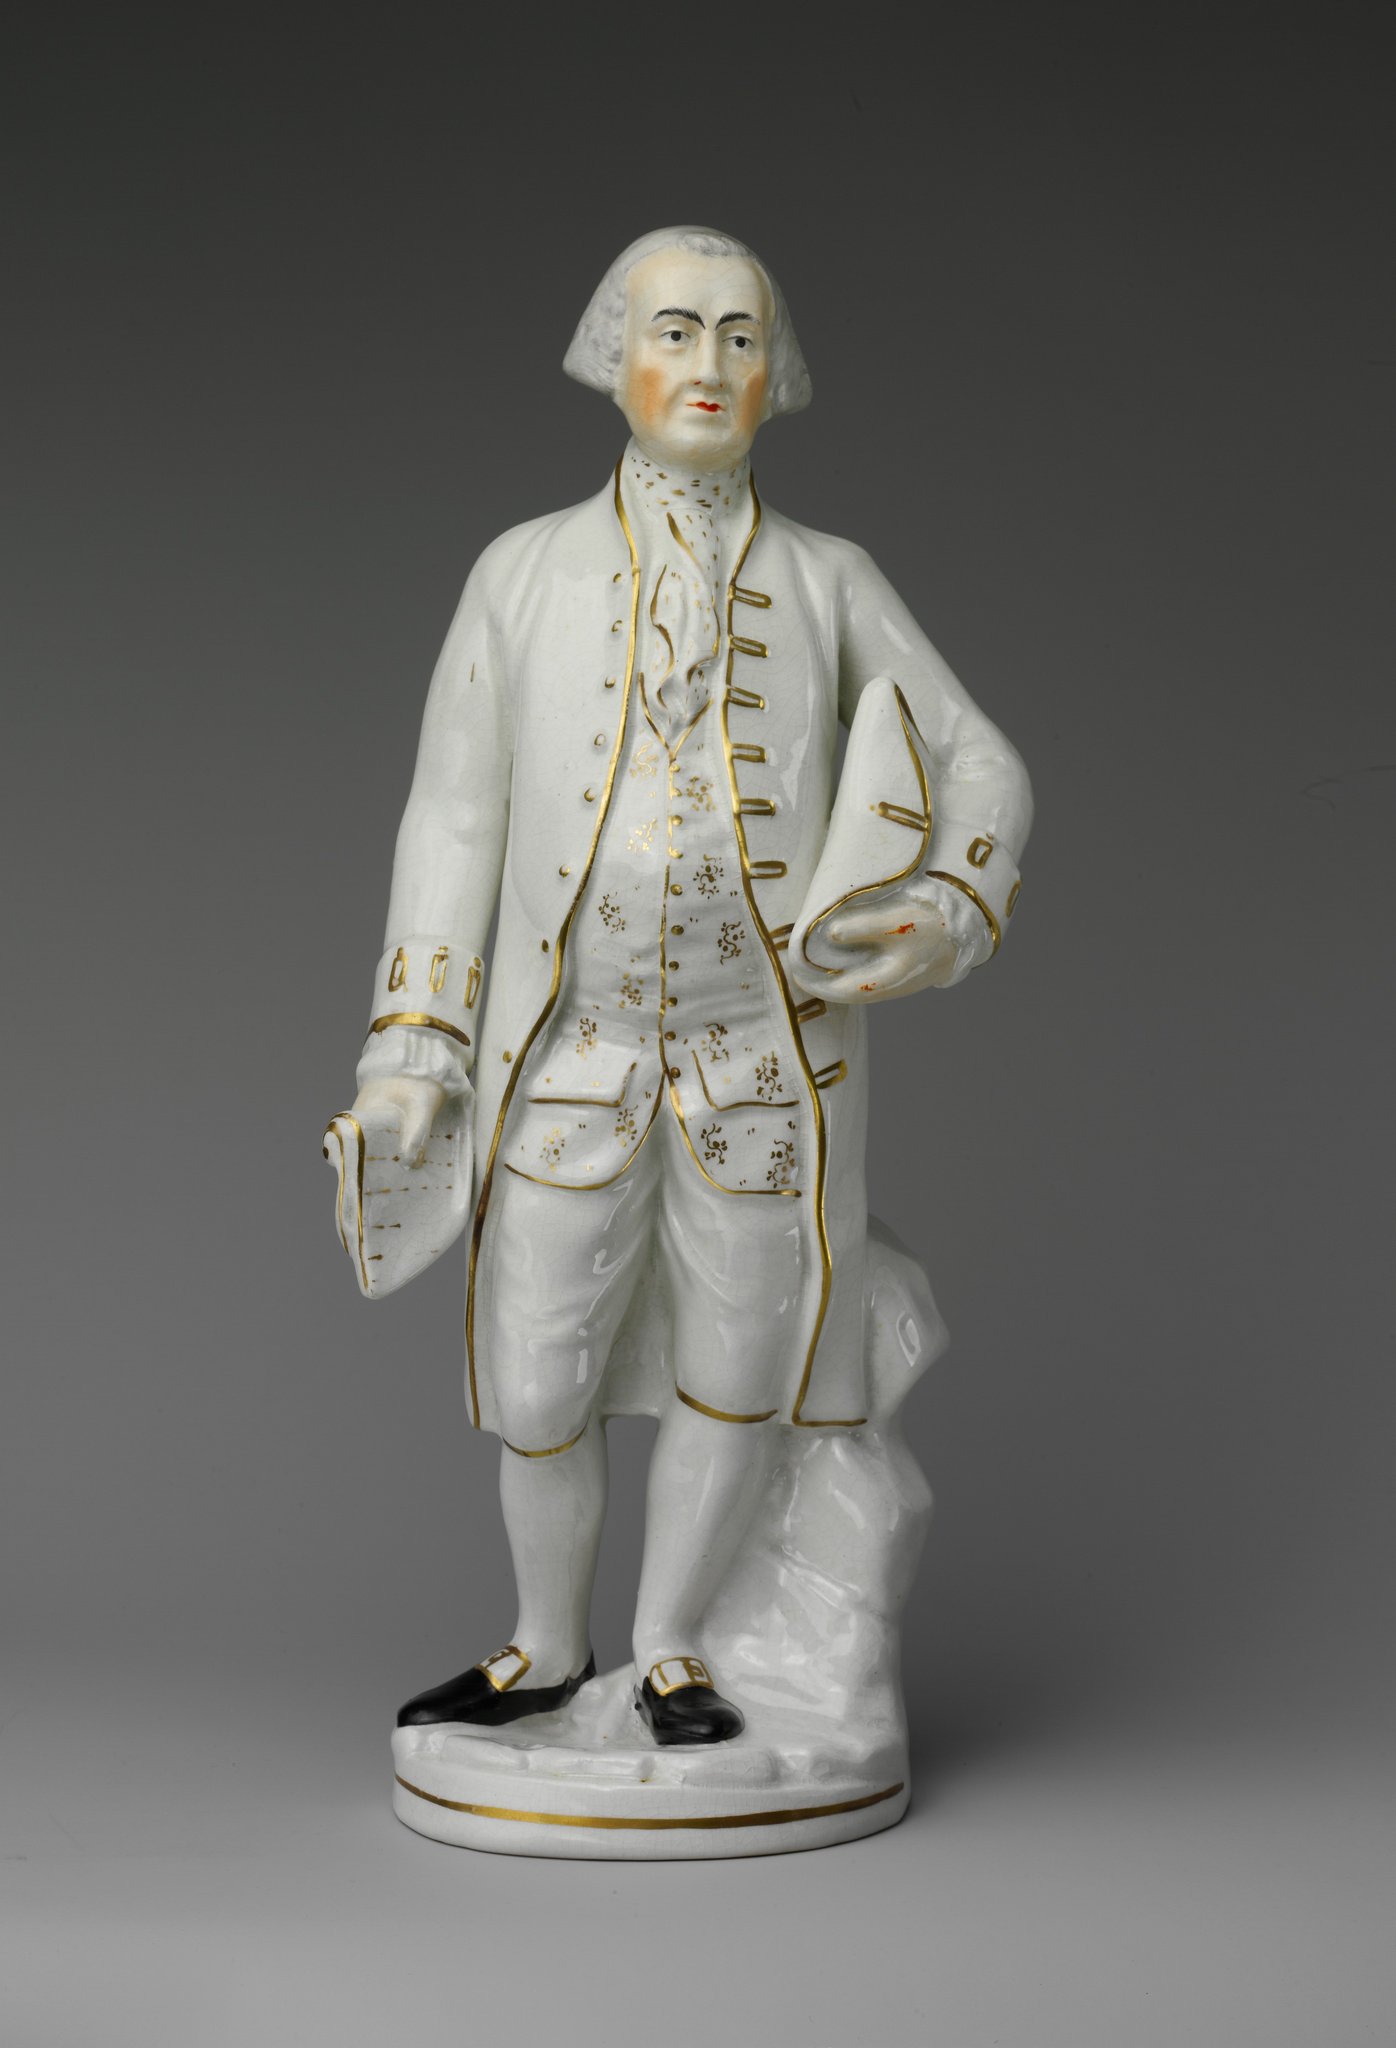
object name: figure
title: George Washington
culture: british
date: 1800-1830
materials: earthenware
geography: england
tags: george washington,men